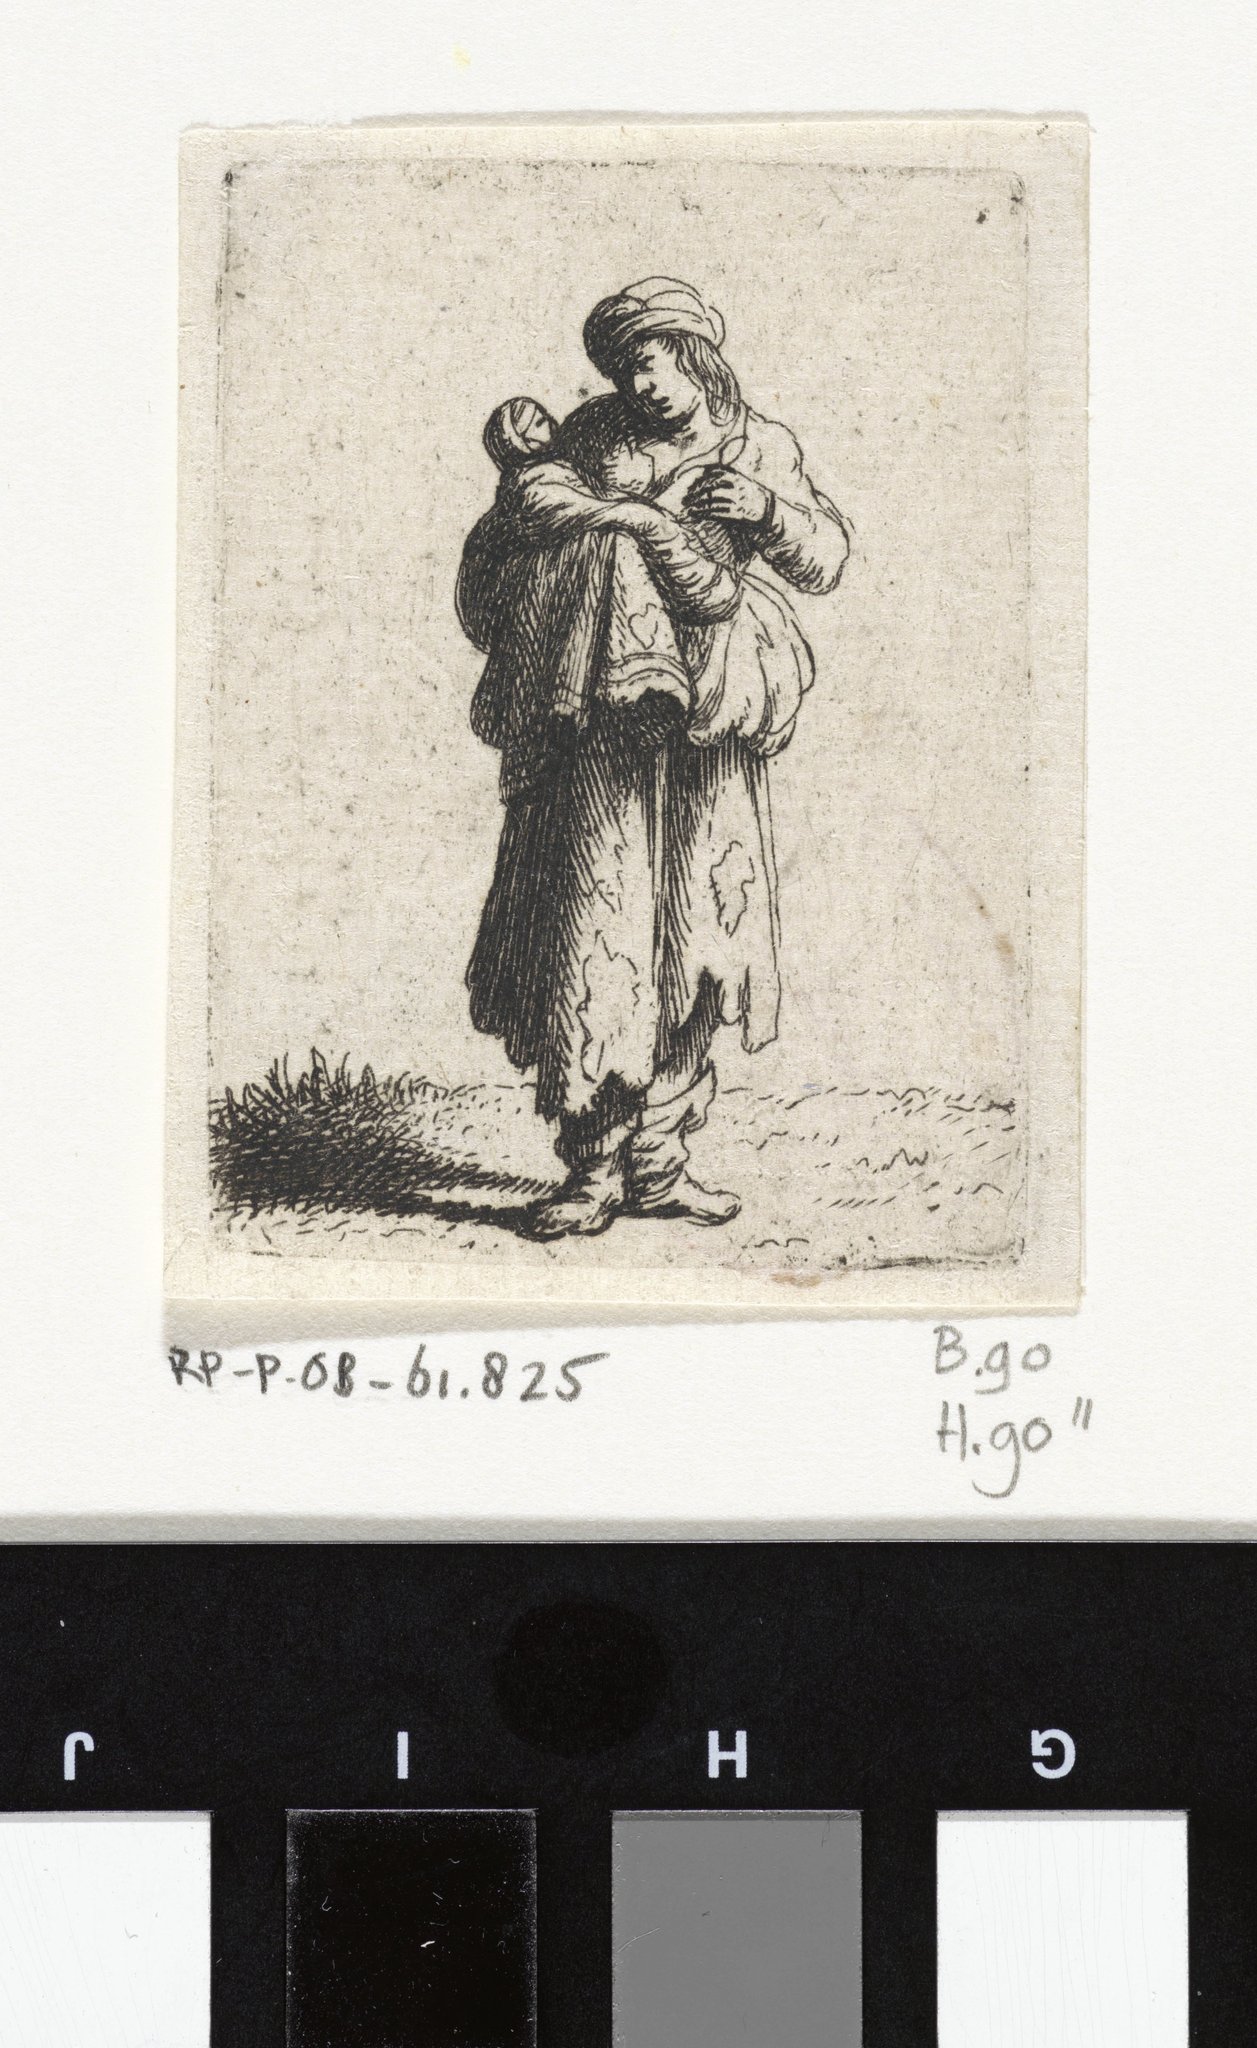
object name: print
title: Vrouw met een ingebakerd kind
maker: jan gillisz. van vliet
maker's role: draughtsman, painter, print maker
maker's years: 1600-1668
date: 1632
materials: paper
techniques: etching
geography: leiden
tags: baby in swaddling clothes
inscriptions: collector's mark: Lugt 240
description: Een staande vrouw in arme kleren met een ingebakerd kind op de arm.